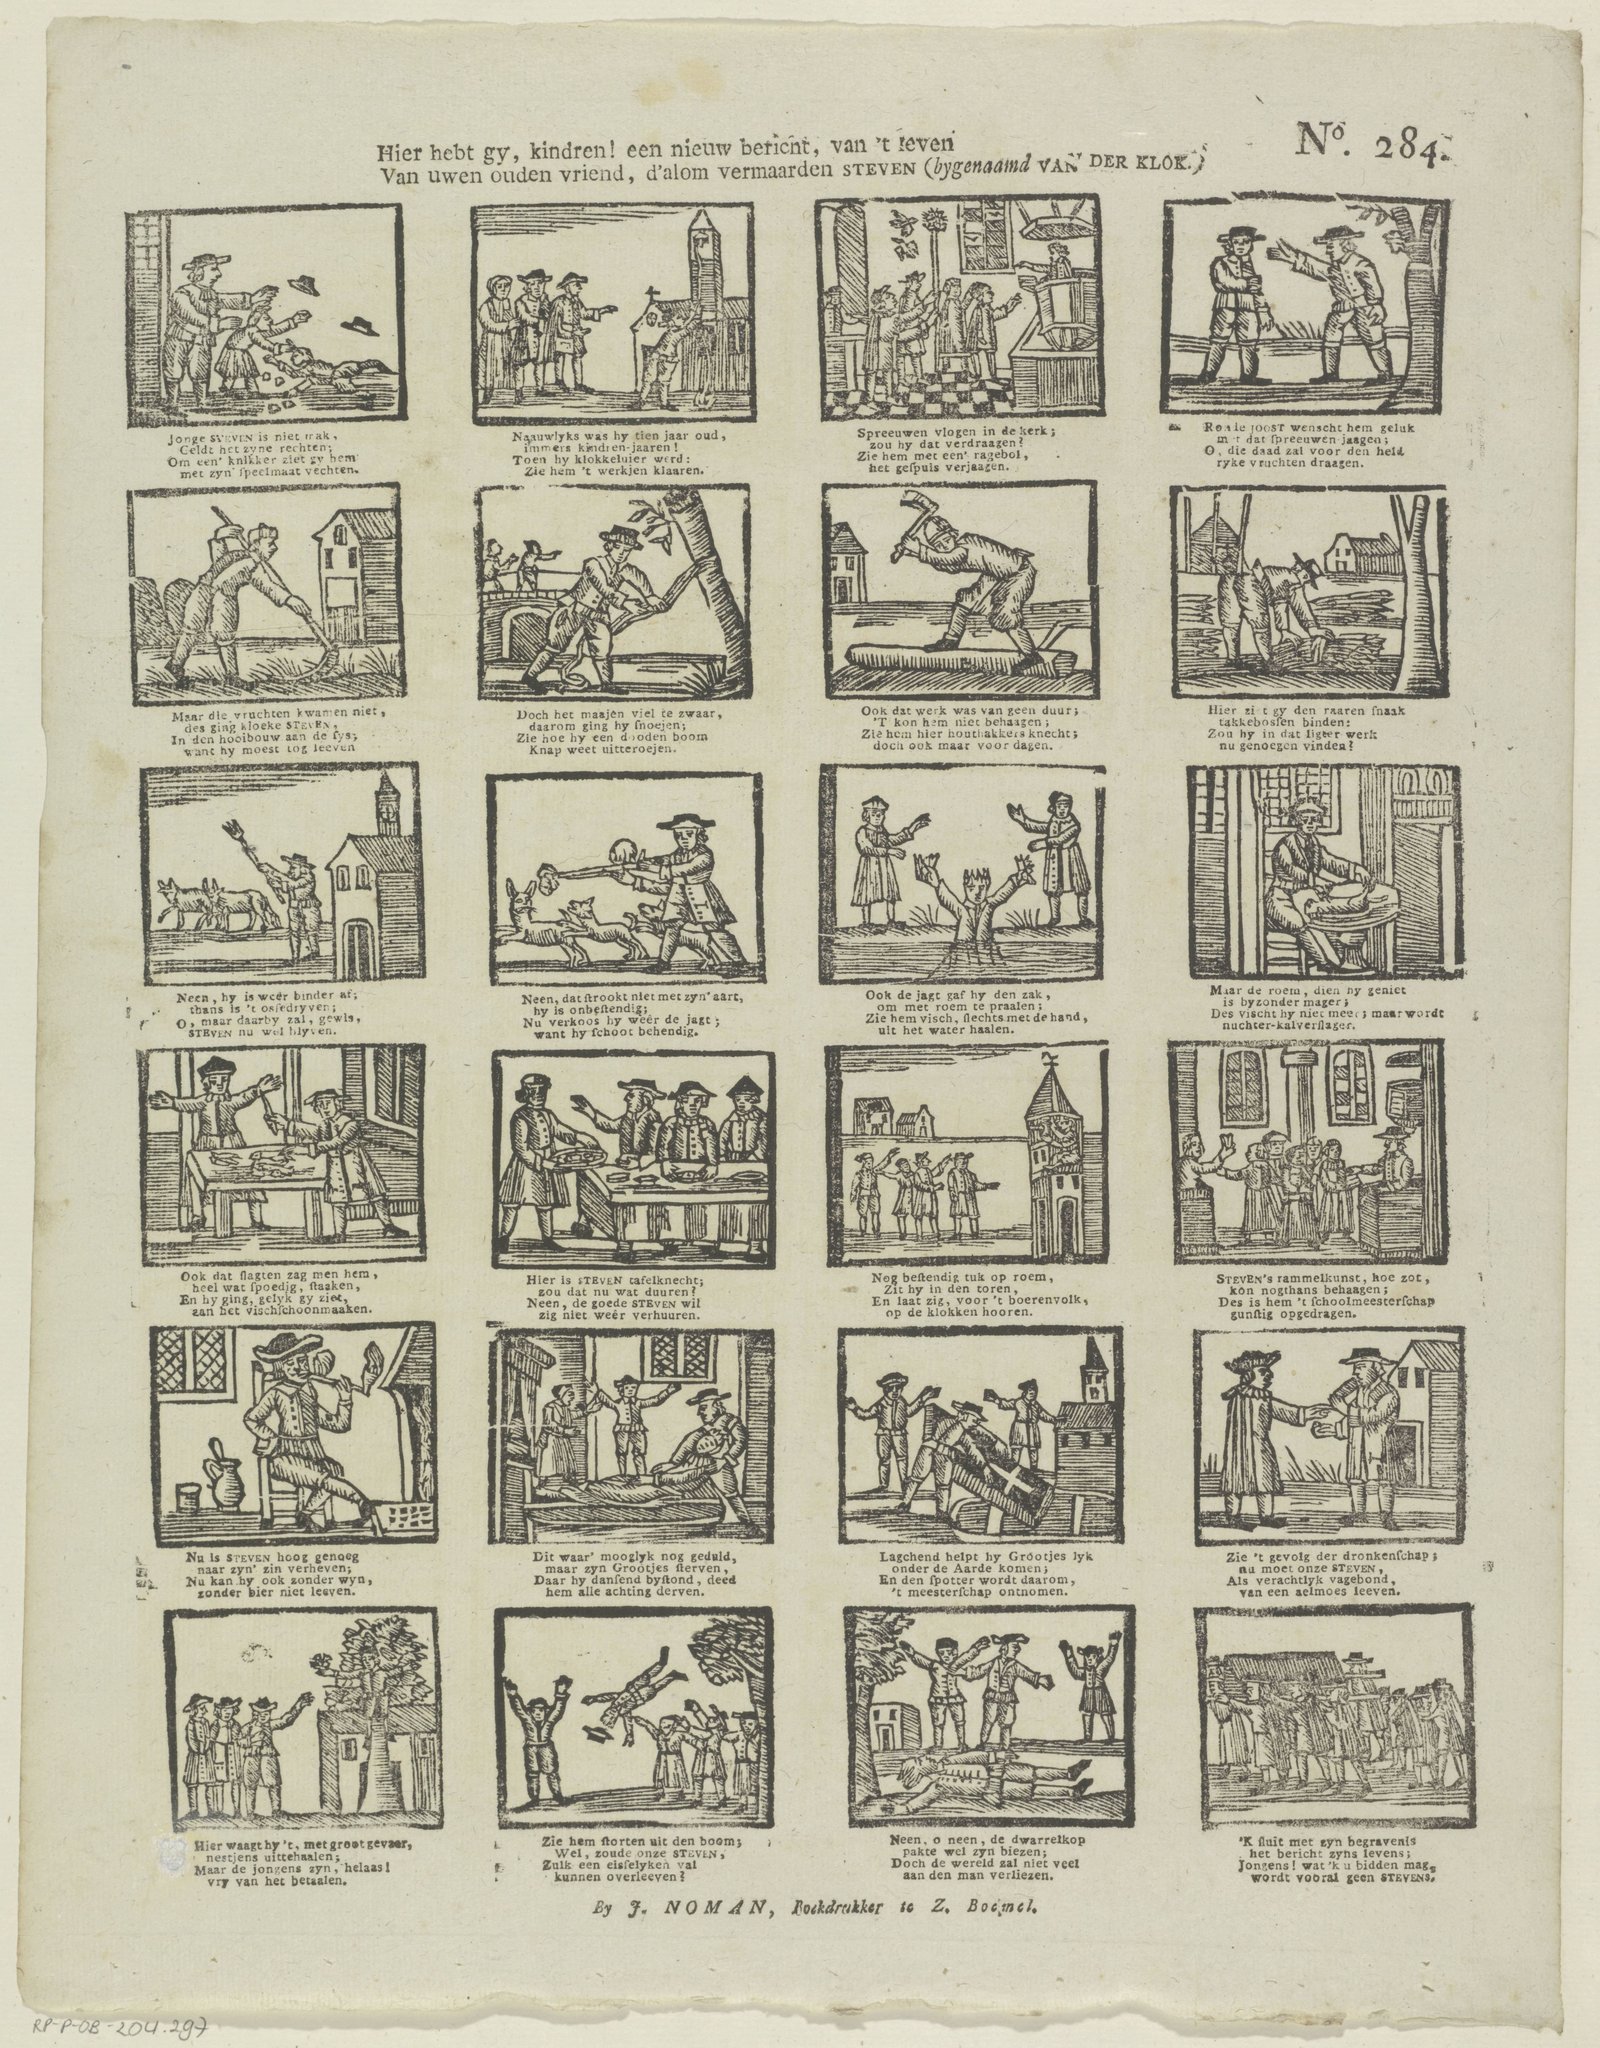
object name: print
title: Hier hebt gy, kindren! een nieuw bericht, van 't leven / Van uwen ouden vriend, d'alom vermaarden Steven (bygenaamd Van der Klok)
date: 1806-1830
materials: paper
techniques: letterpress printing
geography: netherlands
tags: death by accident (non-violent death), funerary ceremonial, tales and fairy tales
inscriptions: collector's mark: Lugt 2760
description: Blad met 24 voorstellingen over het leven van Steven van der Klok. Onder elke afbeelding een vierregelig vers. Genummerd rechtsboven: No. 284.